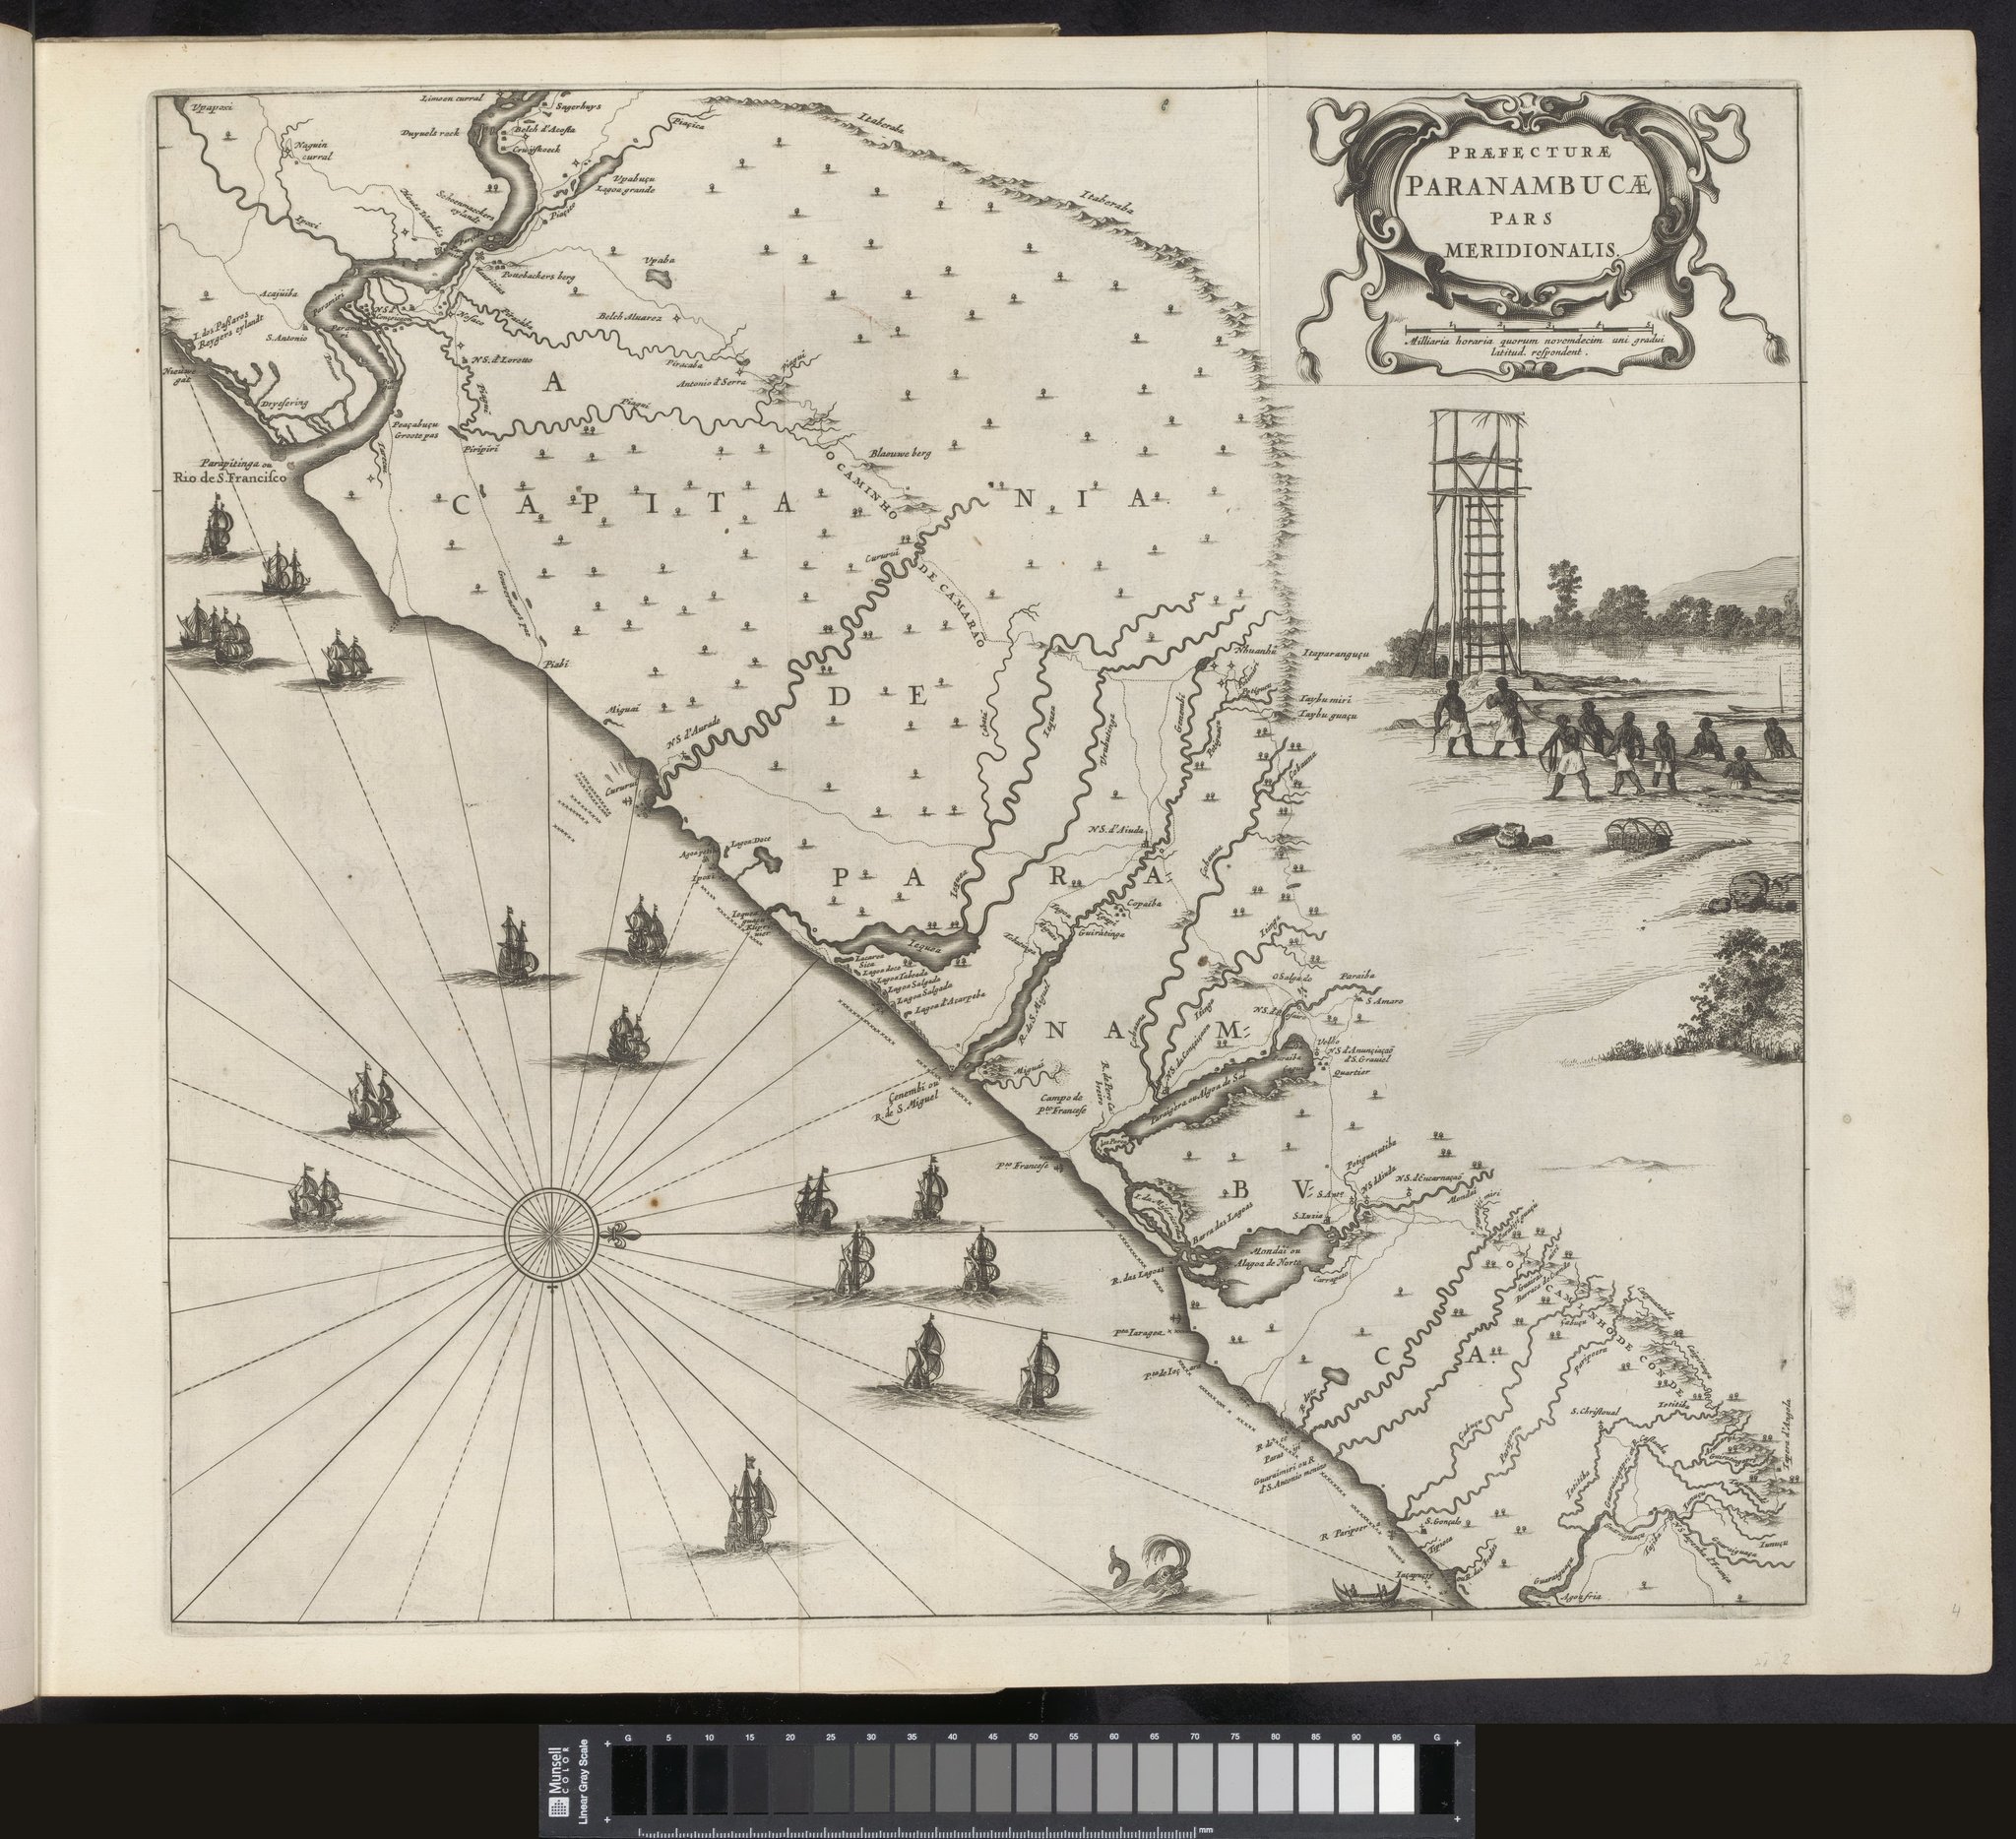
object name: print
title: Praefectura Paranambucae pars merodionalis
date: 1645-1647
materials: paper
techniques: engraving, etching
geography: northern netherlands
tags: earl, johan maurits graaf van nassau-siegen, maps of separate countries or regions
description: Illustratie in: Caspar Barlaeus, Rerum per octennium in Brasilia et alibi nuper gestarum sub praefectura J. Mauritii, Nassoviae, c. comitis... historia, Joannes Blaeu, Amsterdam 1647, plaat [nr. 2] p. 24/25. Prent in het exemplaar in de collectie van de Rijksmuseum Research Library, standplaats 330 A 18.